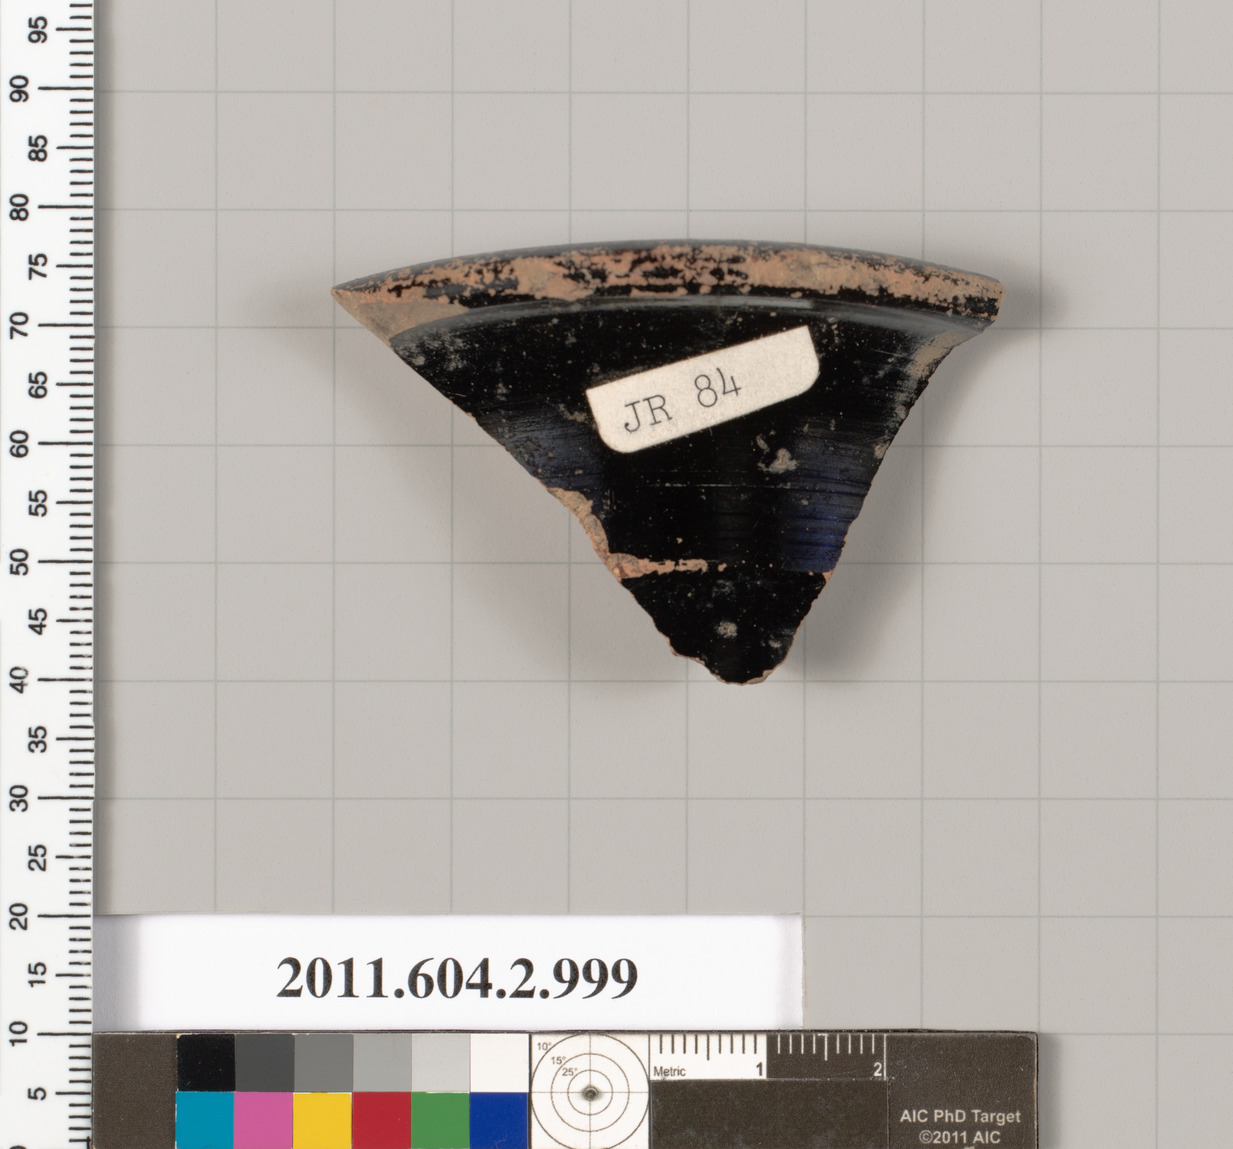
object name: olpe fragment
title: Terracotta fragment of an oinochoe: olpe (jug)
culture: greek, attic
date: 460-440 BCE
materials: terracotta